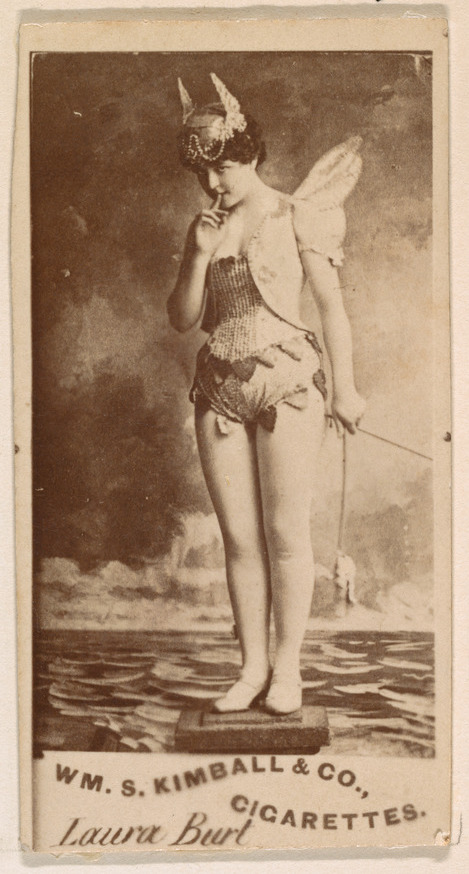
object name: photograph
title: Laura Burt, from the Actresses series (N203) issued by Wm. S. Kimball & Co.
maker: william s. kimball & company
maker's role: publisher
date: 1889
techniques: color lithograph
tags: portraits,women,actresses